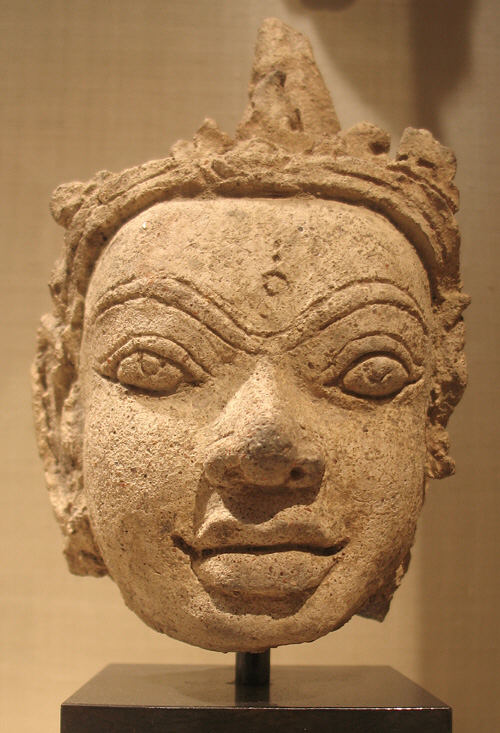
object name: head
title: Head of a Deity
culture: thai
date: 701-800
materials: plaster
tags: heads